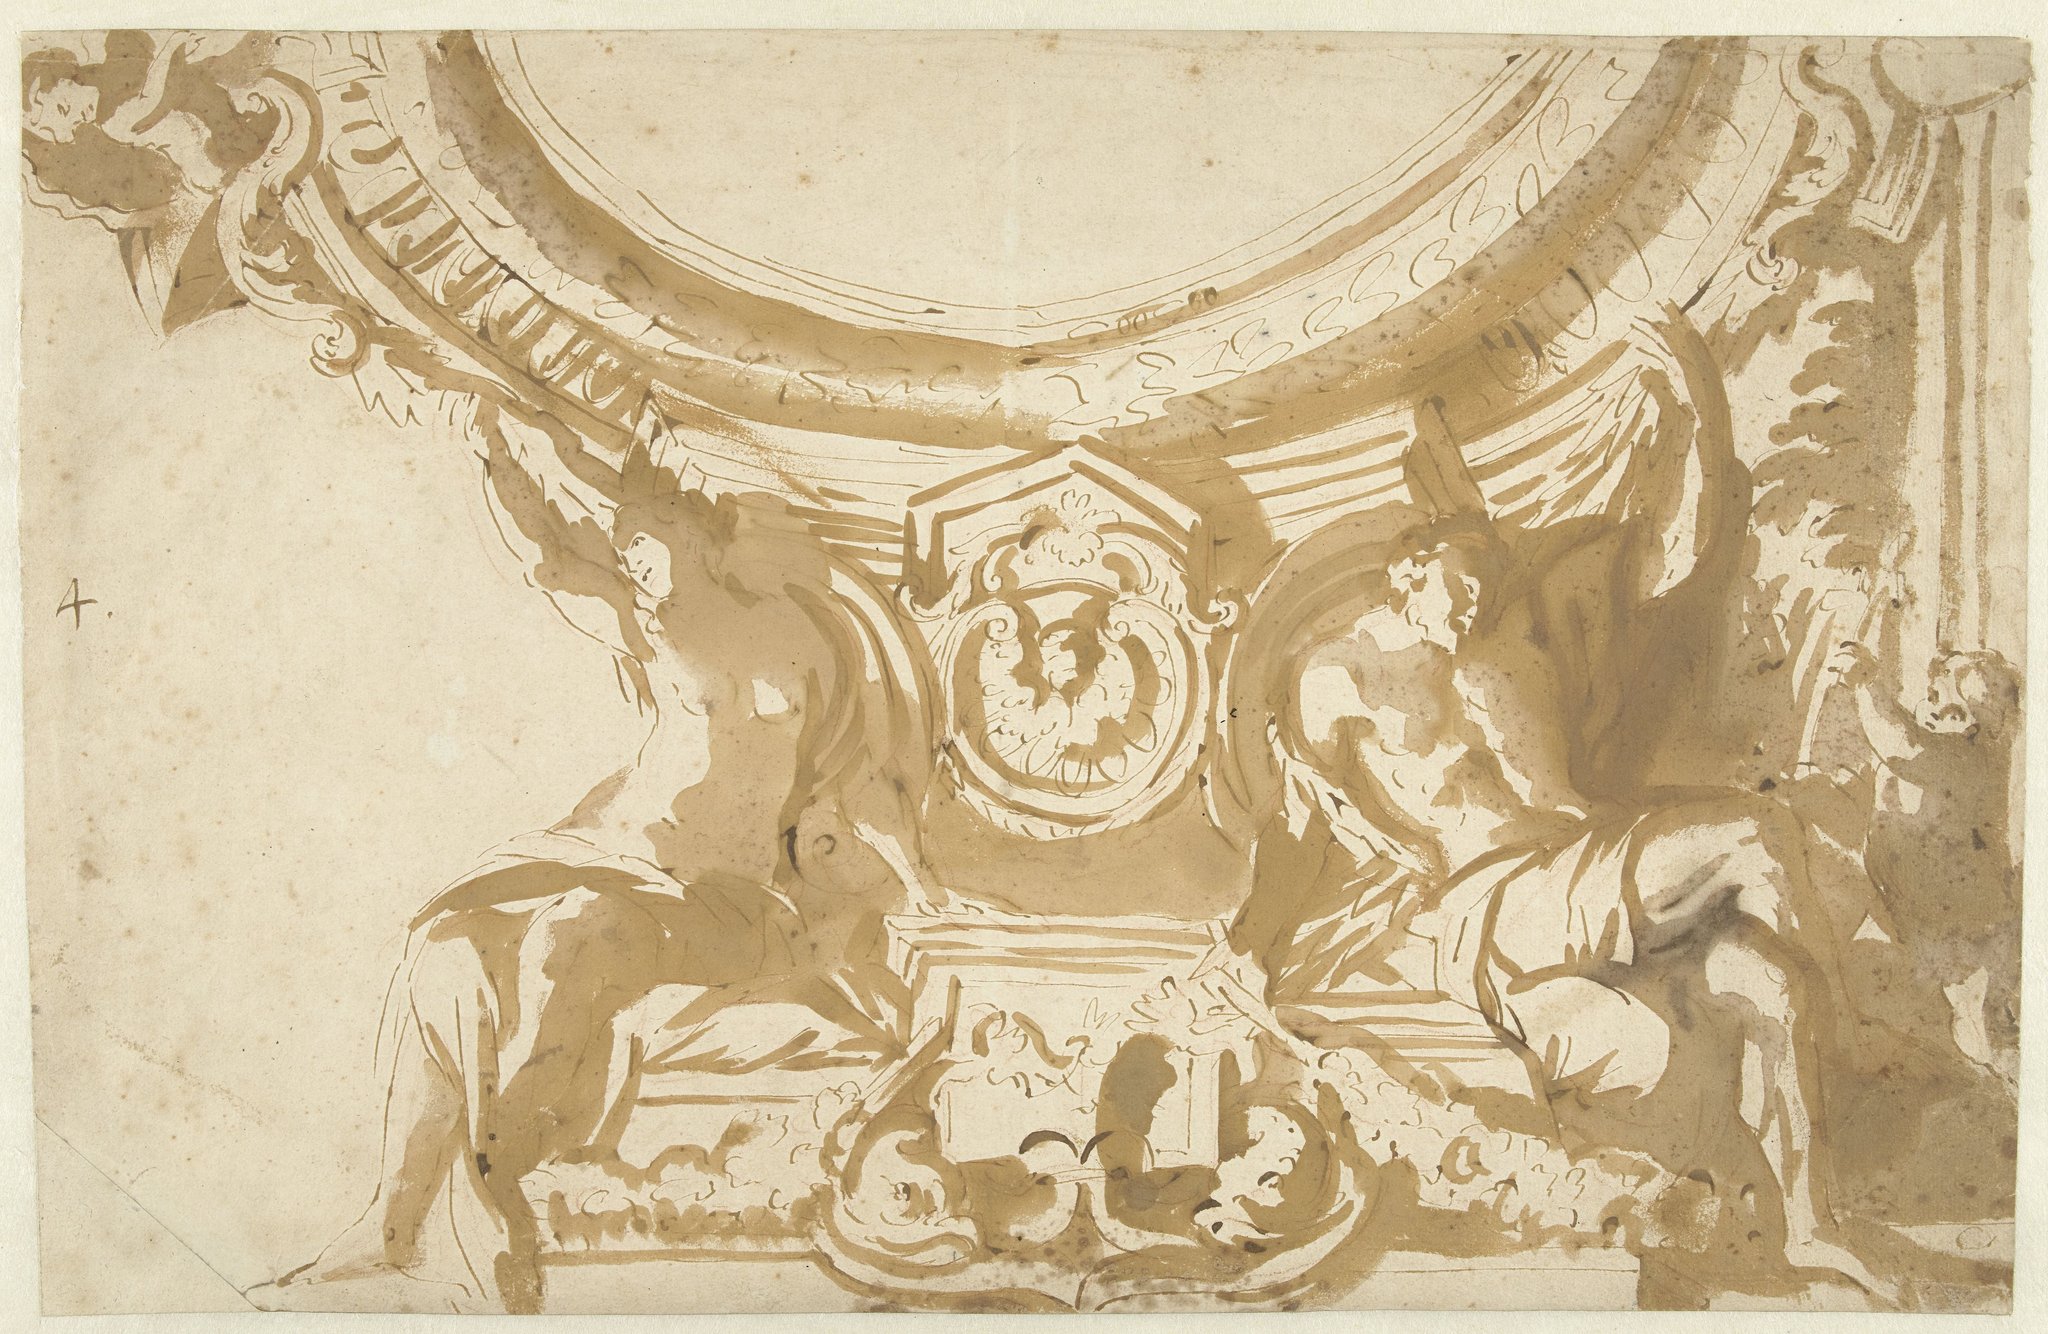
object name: drawing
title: Ontwerp voor een plafond met twee dragende figuren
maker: augustinus terwesten (i)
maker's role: draughtsman, painter, print maker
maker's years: 1649-1711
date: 1659-1711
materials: chalk, ink, paper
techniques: brush, pen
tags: (decorated) ceiling